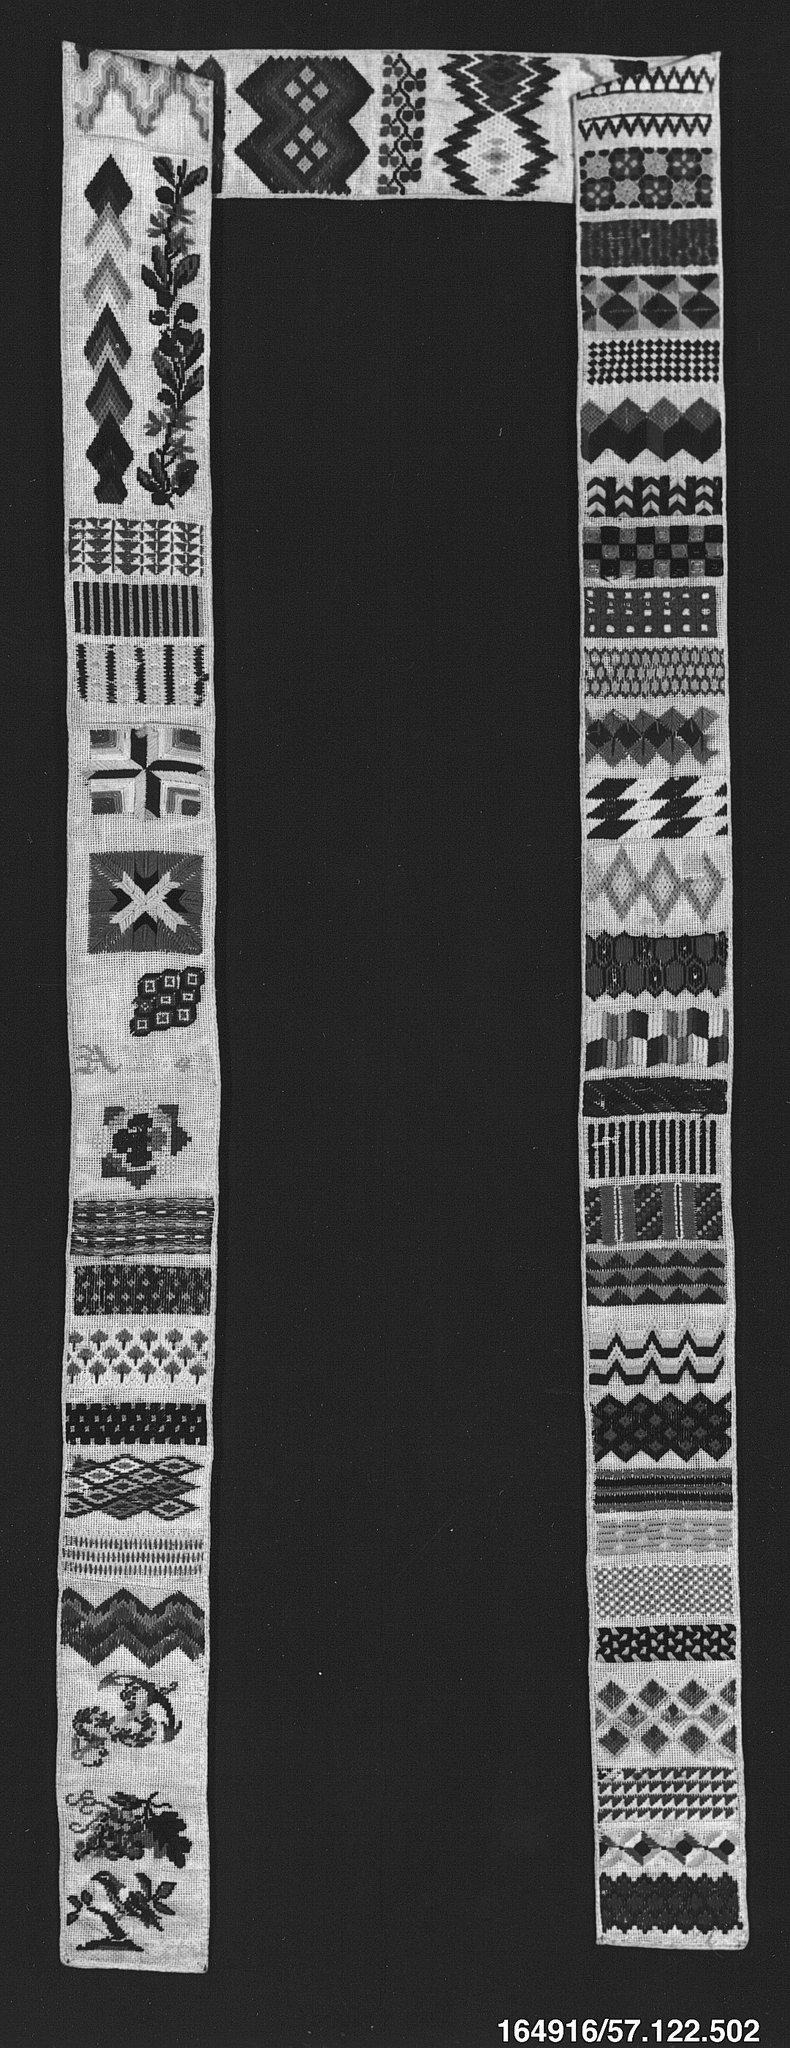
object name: sampler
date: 1801-1900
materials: canvas, wool